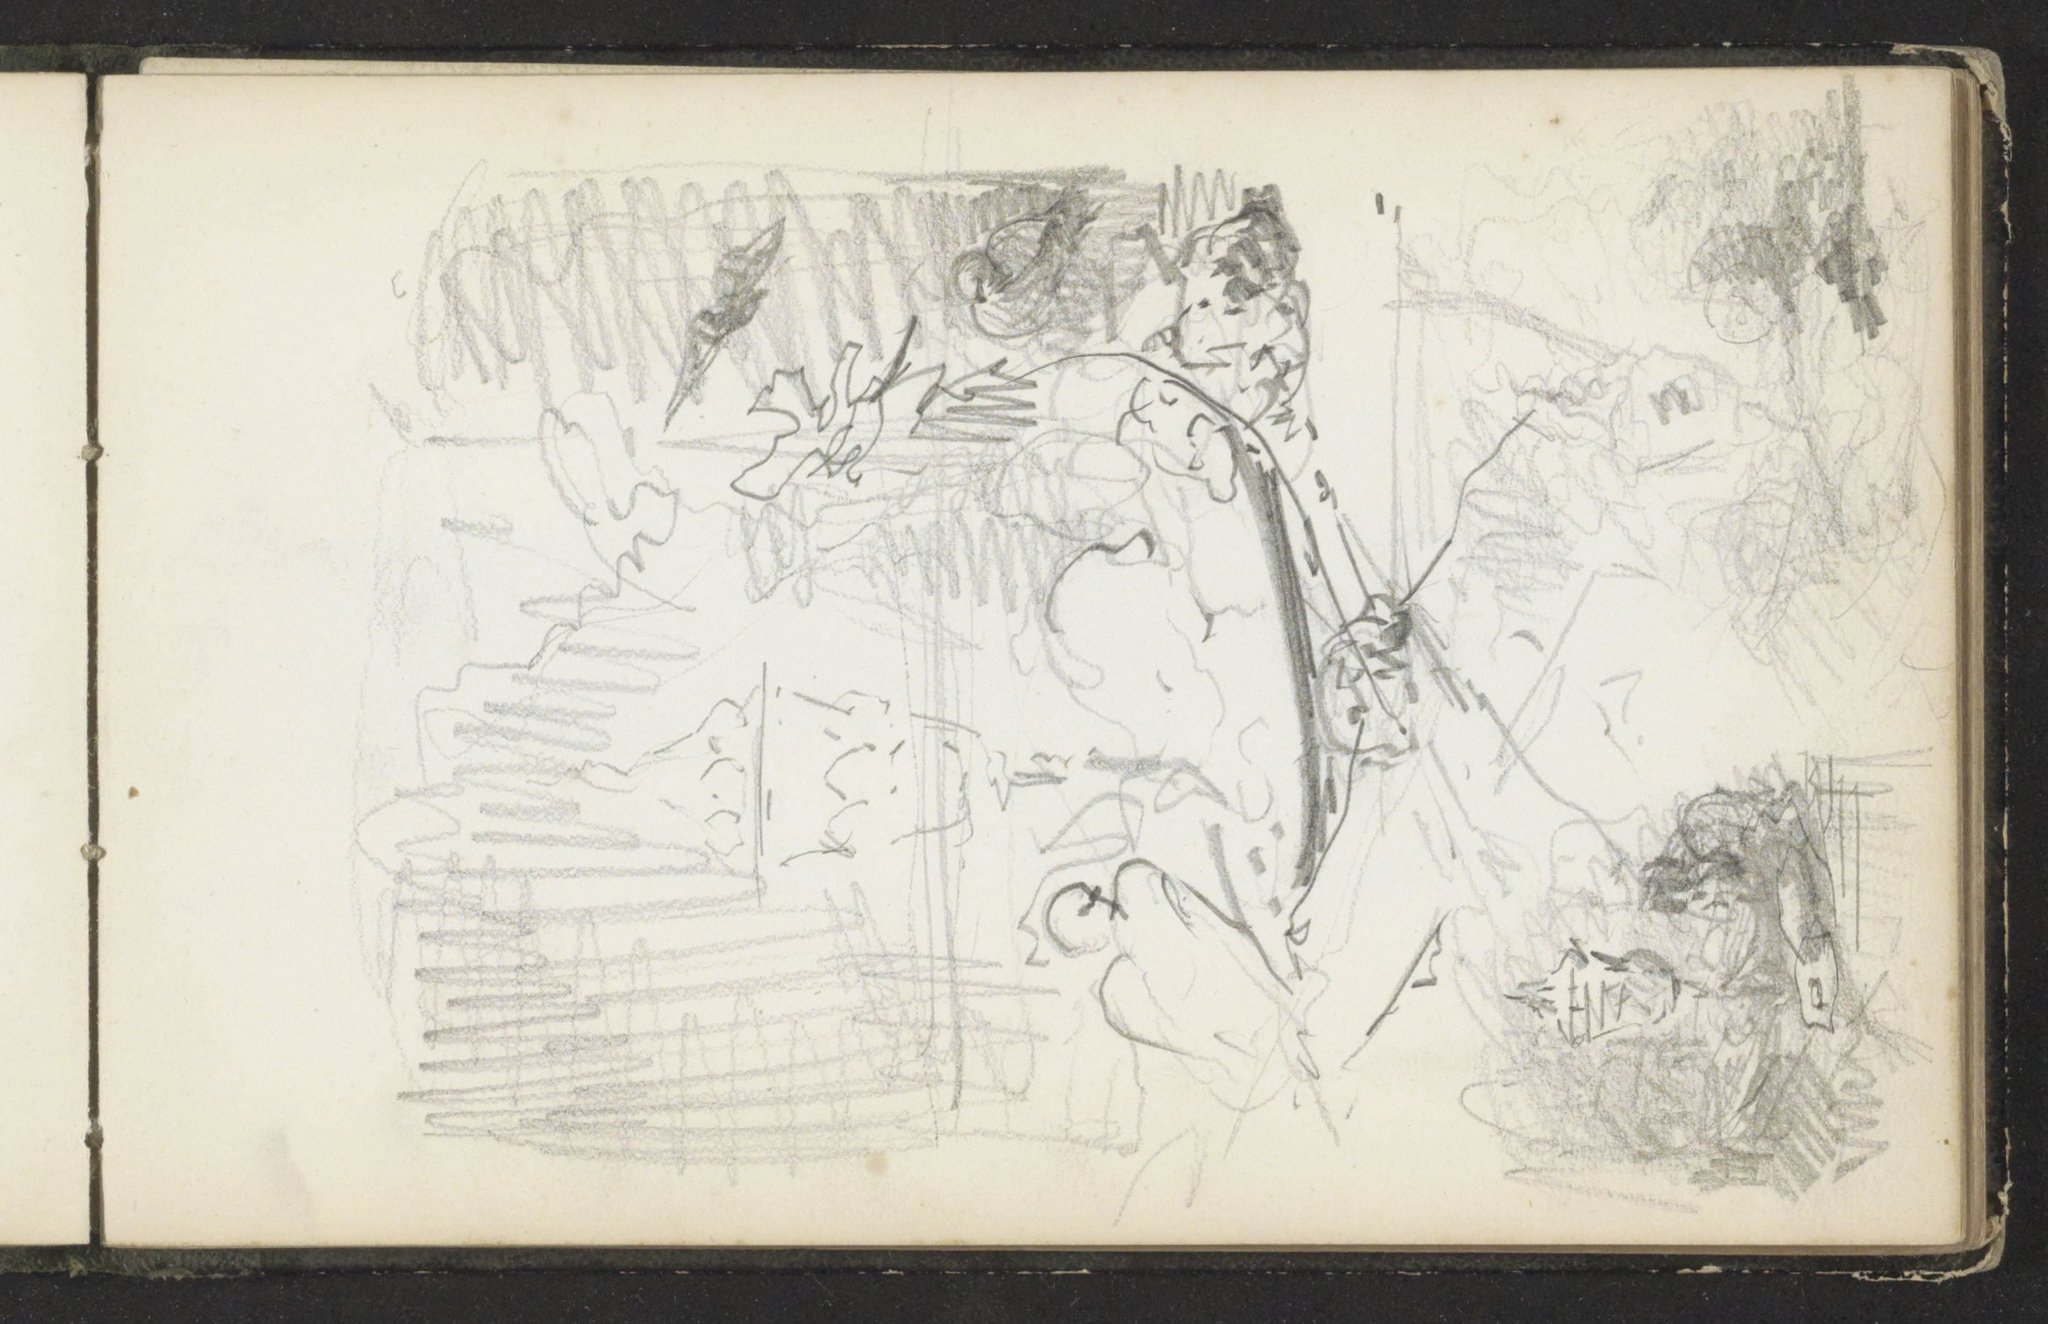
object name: sketchbook leaf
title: Stillevens met een duif, kelk en diverse voorwerpen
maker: maria vos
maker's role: draughtsman, painter, print maker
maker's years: 1824-1906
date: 1856-1870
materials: paper, pencil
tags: still life of miscellaneous objects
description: Blad 23 recto uit een schetsboek met 39 bladen.